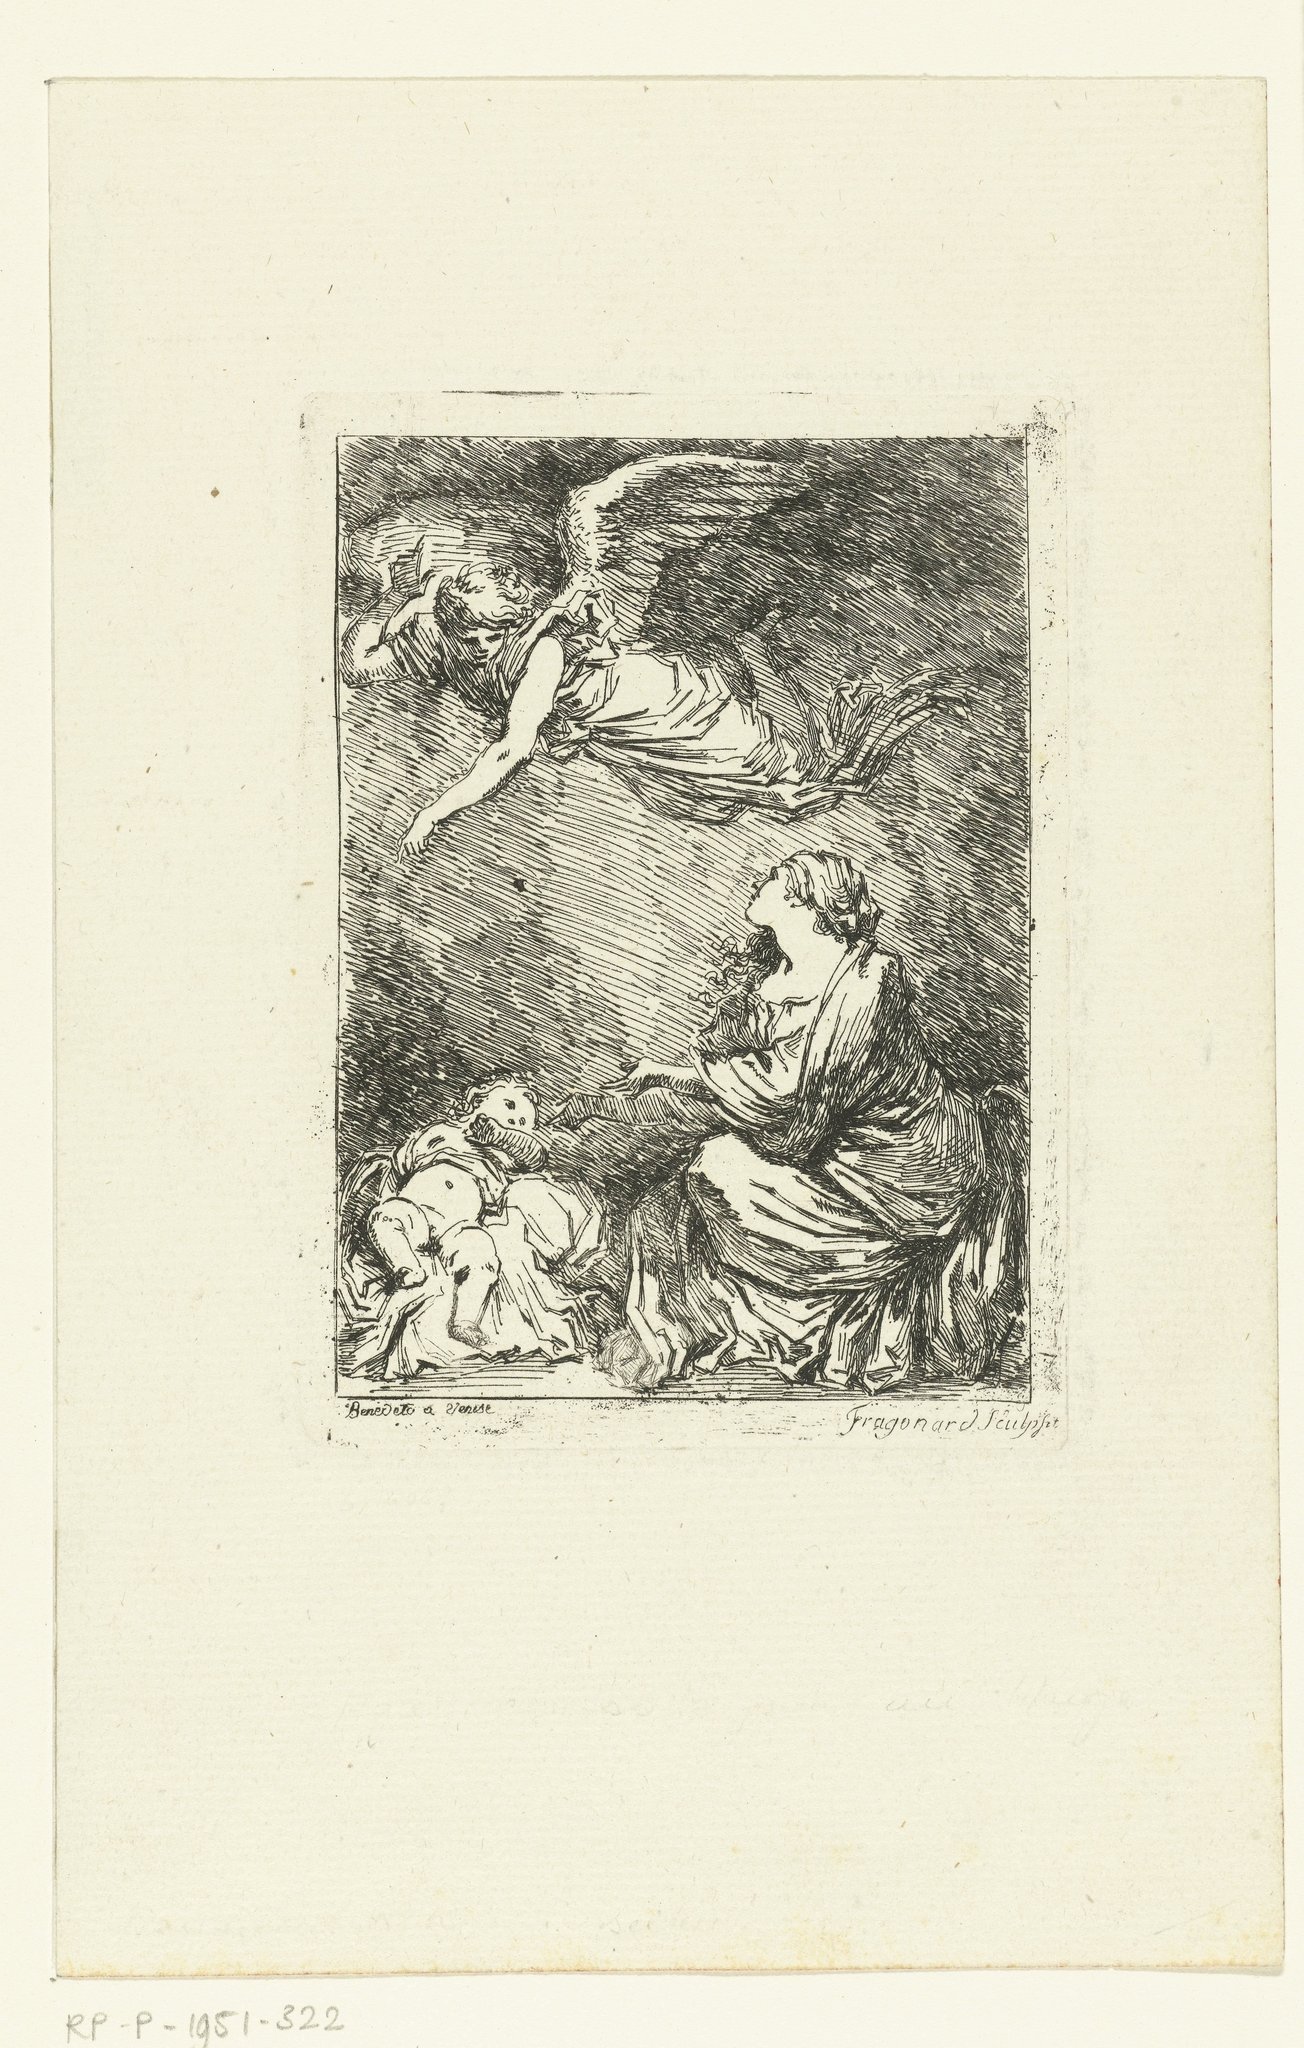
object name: print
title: Engel wijst Hagar de waterbron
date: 1763-1764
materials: paper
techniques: etching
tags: an angel appears and reveals a well of water to hagar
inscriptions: collector's mark: Lugt 2228, collector's mark: Lugt 2760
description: Hagar zittend op de grond, naast haar ligt Ismaël. Zij kijkt omhoog naar een engel die haar een waterbron zal wijzen.